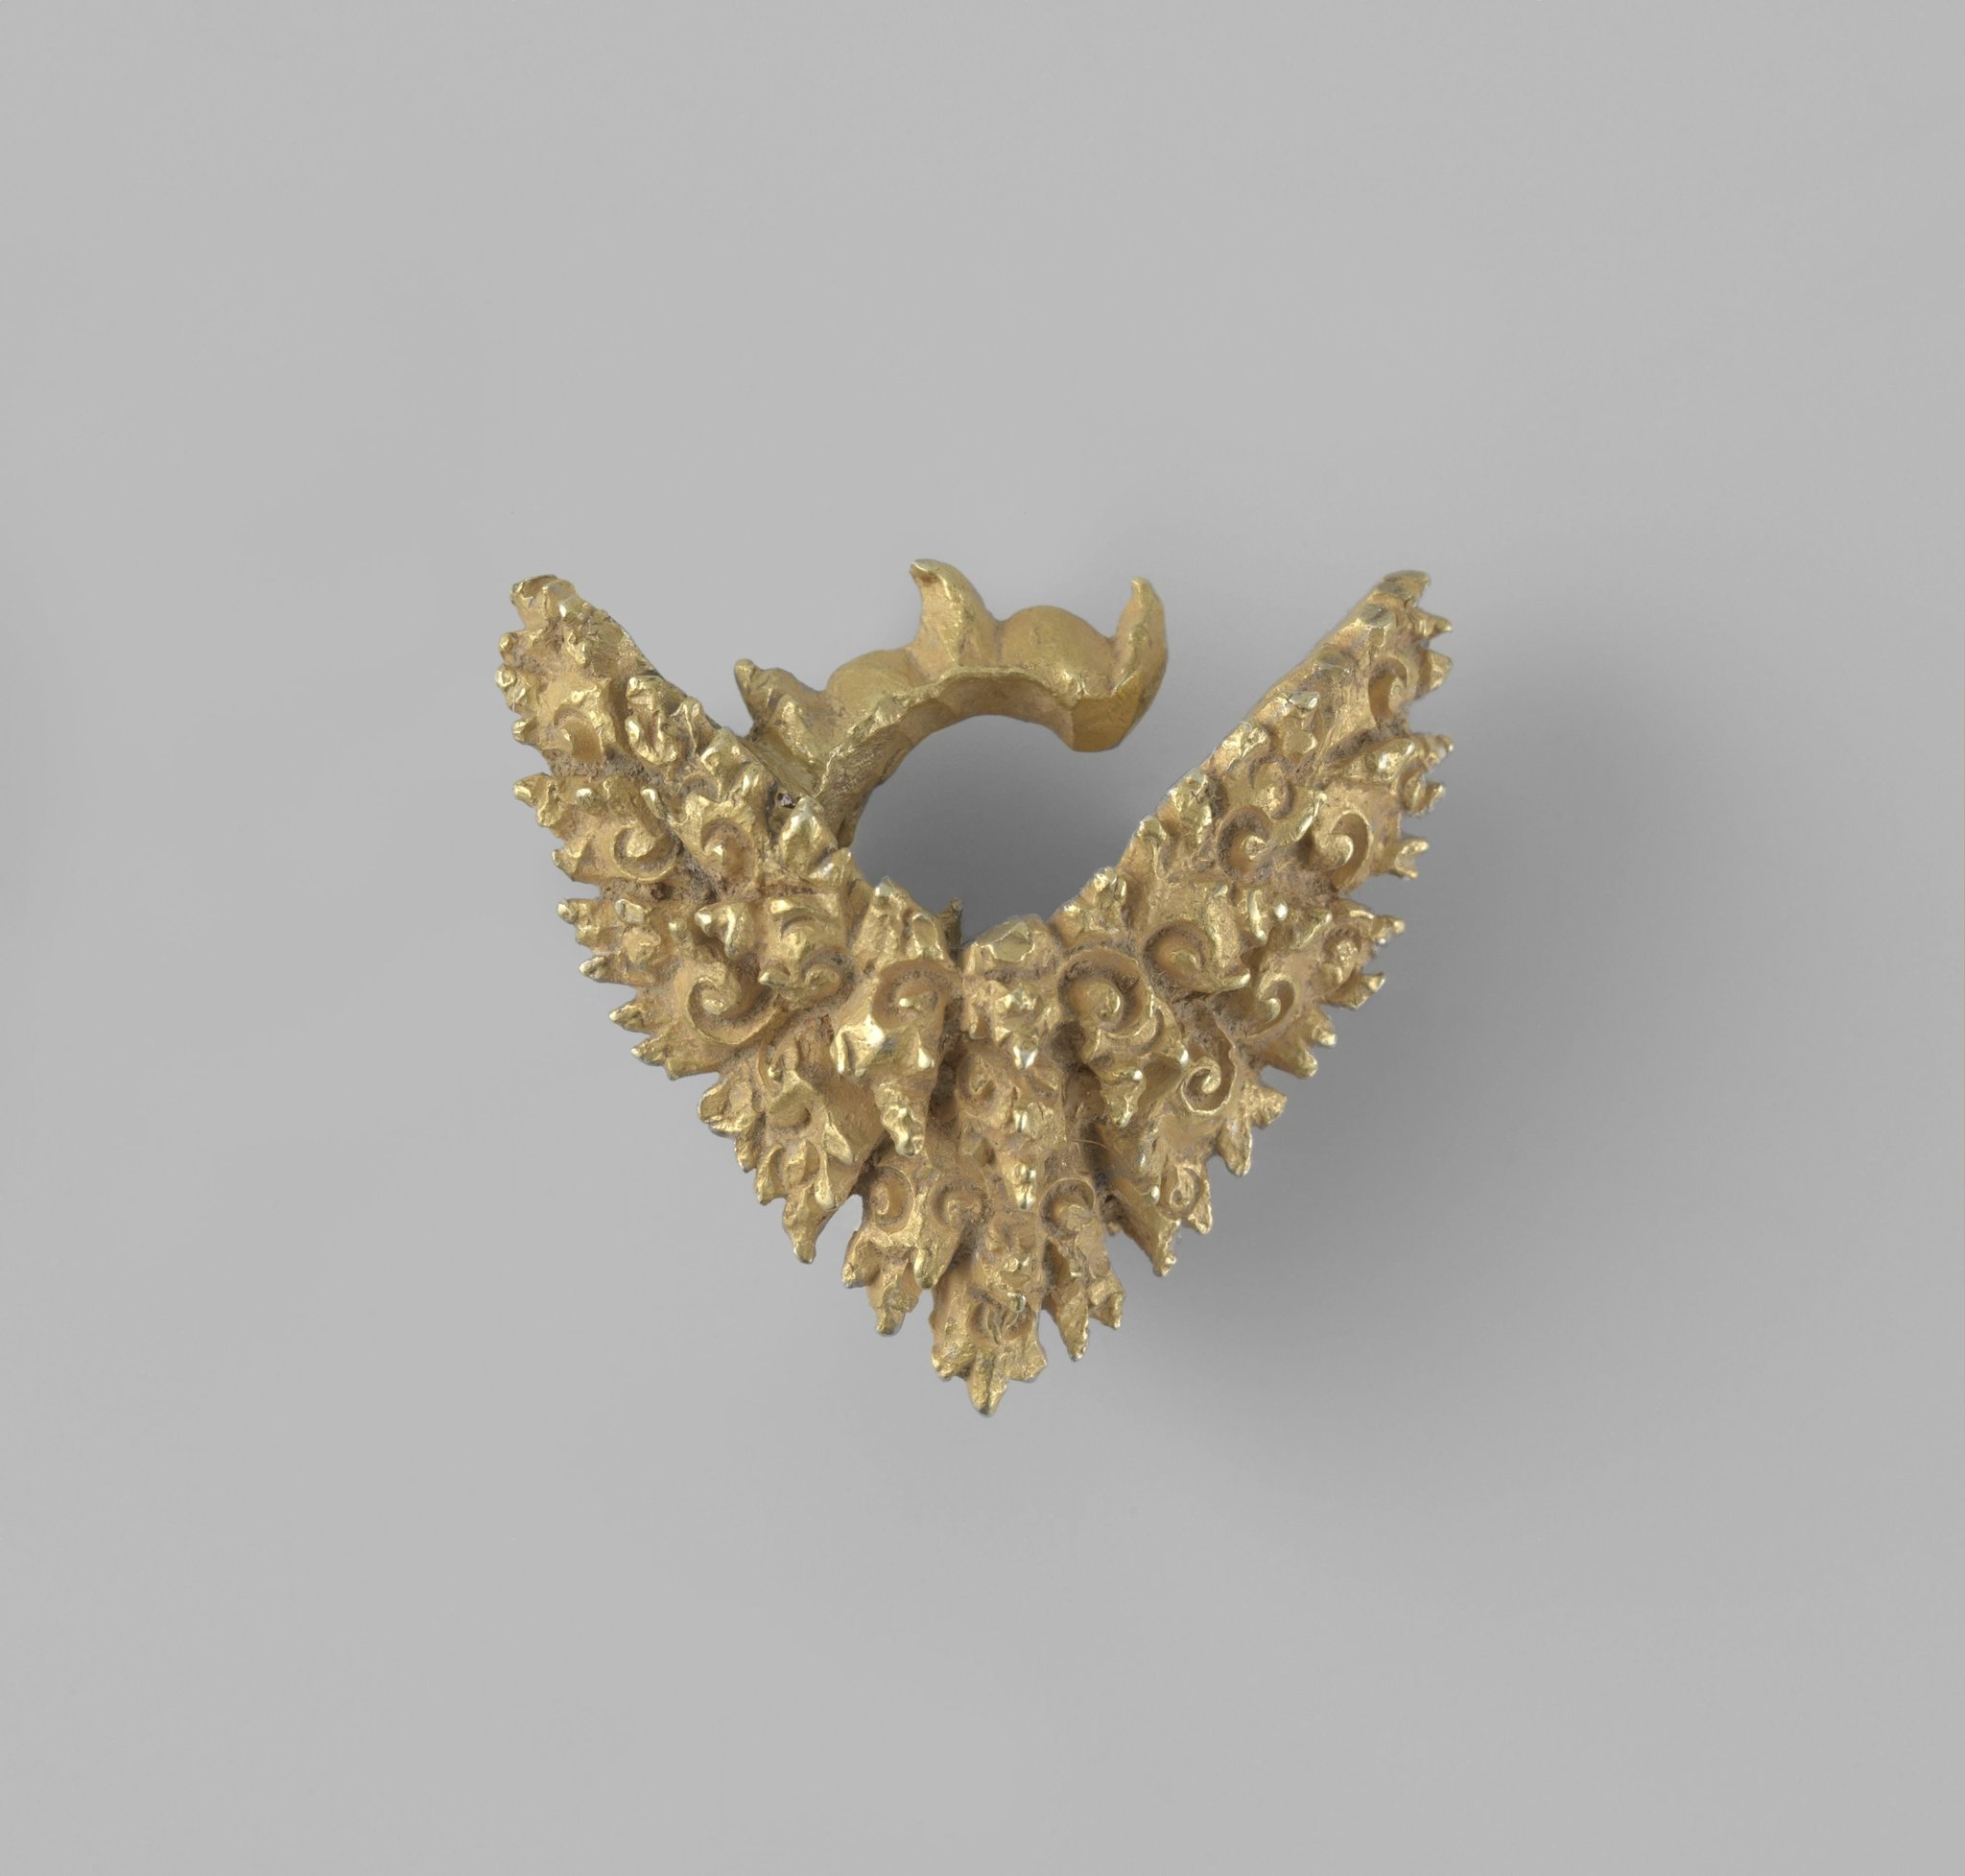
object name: ear ornament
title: Oorsieraad van goud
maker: Anonymous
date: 1045-1500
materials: gold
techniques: casting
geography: java